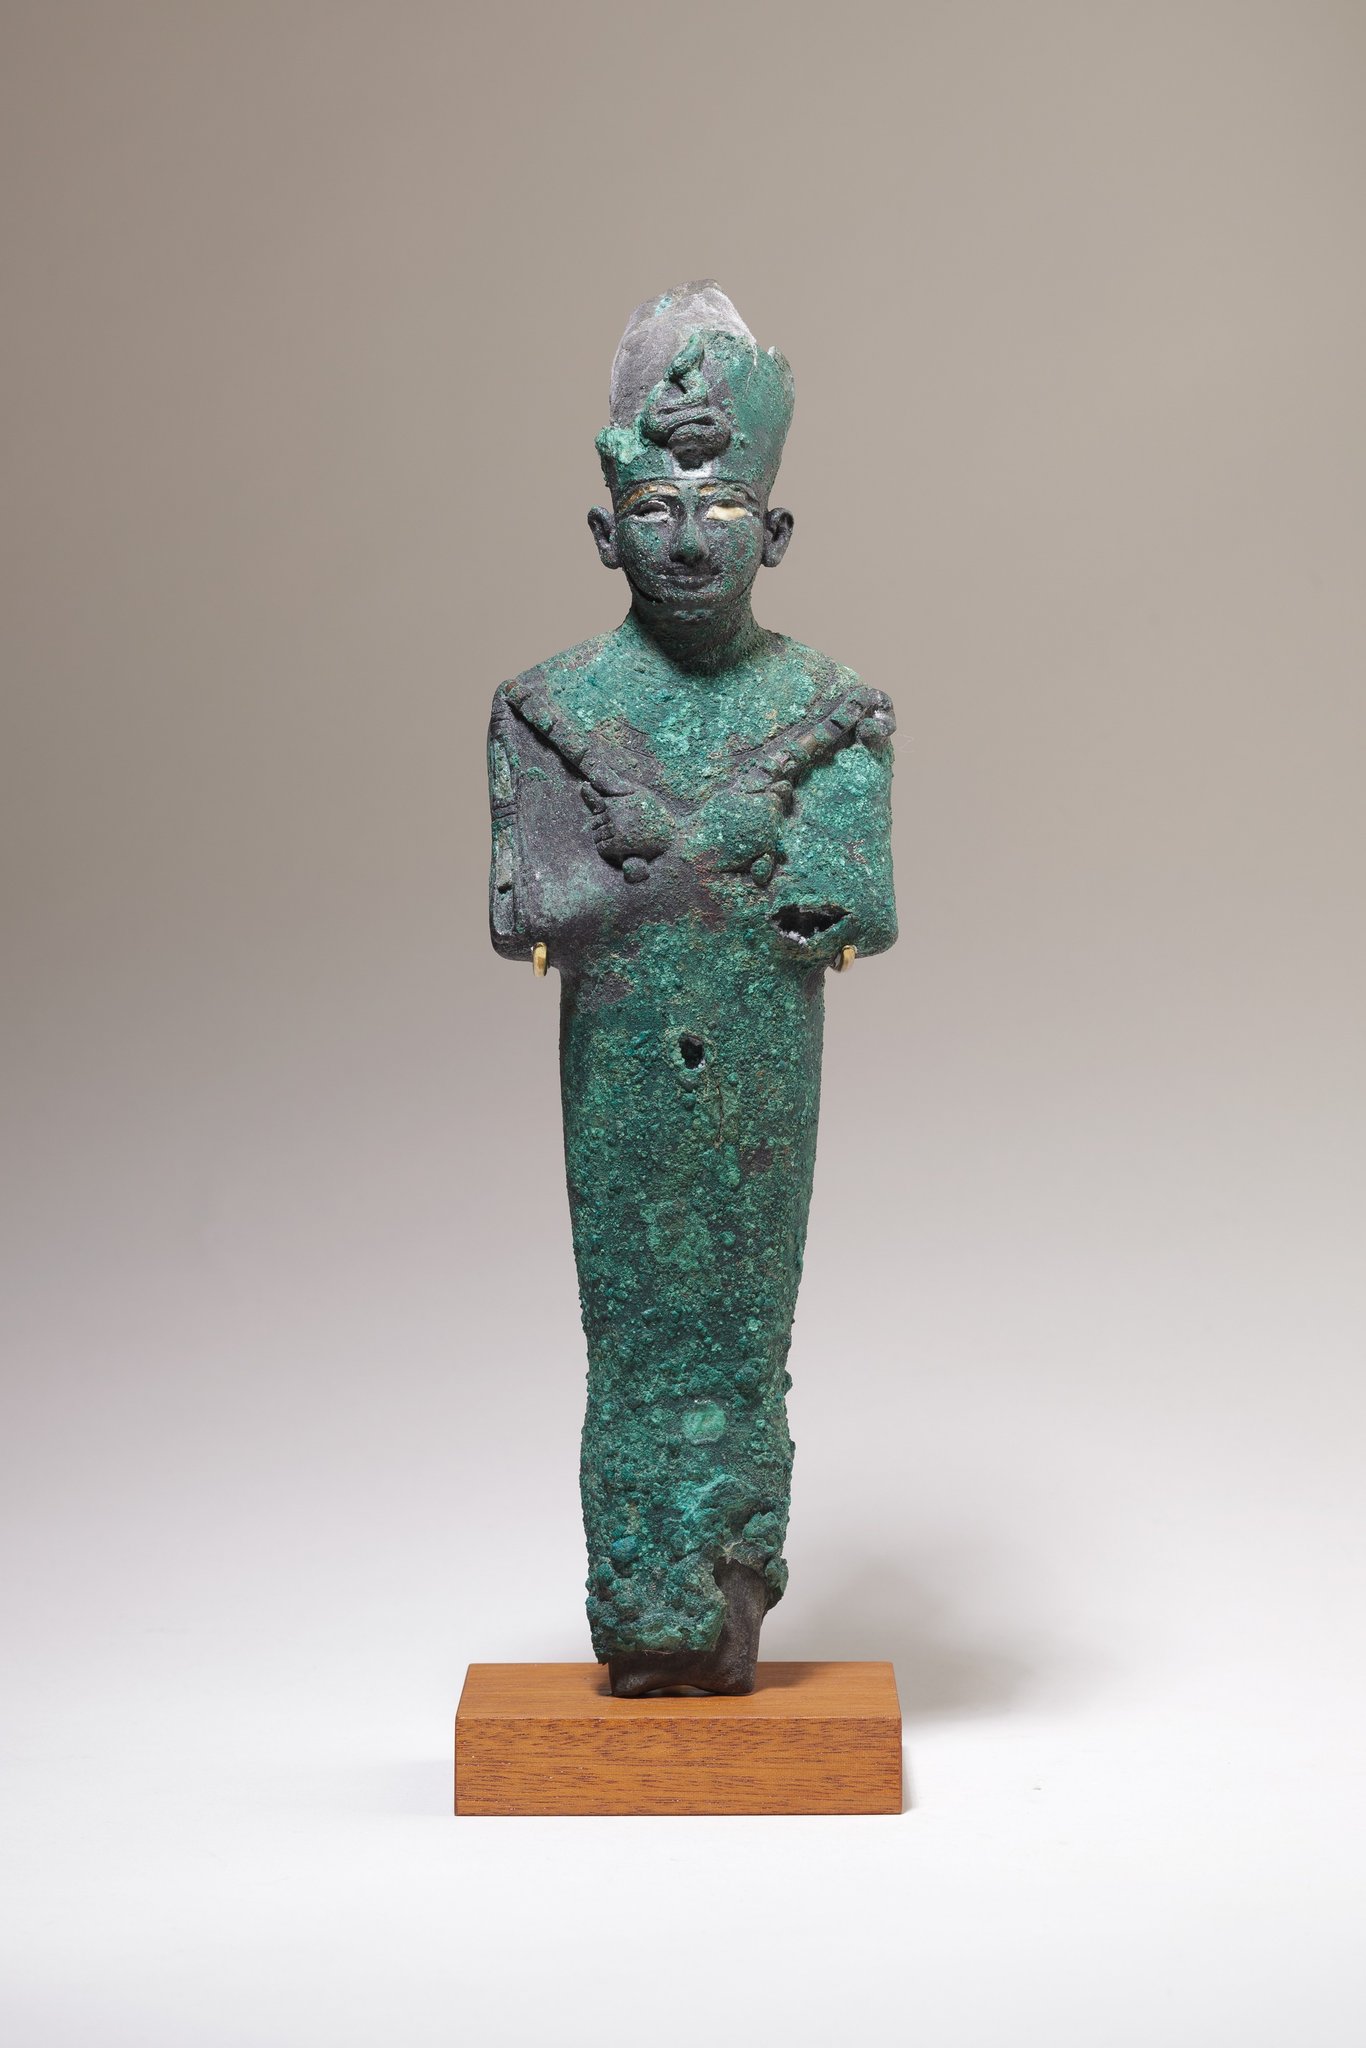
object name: statuette, osiris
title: Osiris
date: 1070-664 BCE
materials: copper alloy, stone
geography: egypt